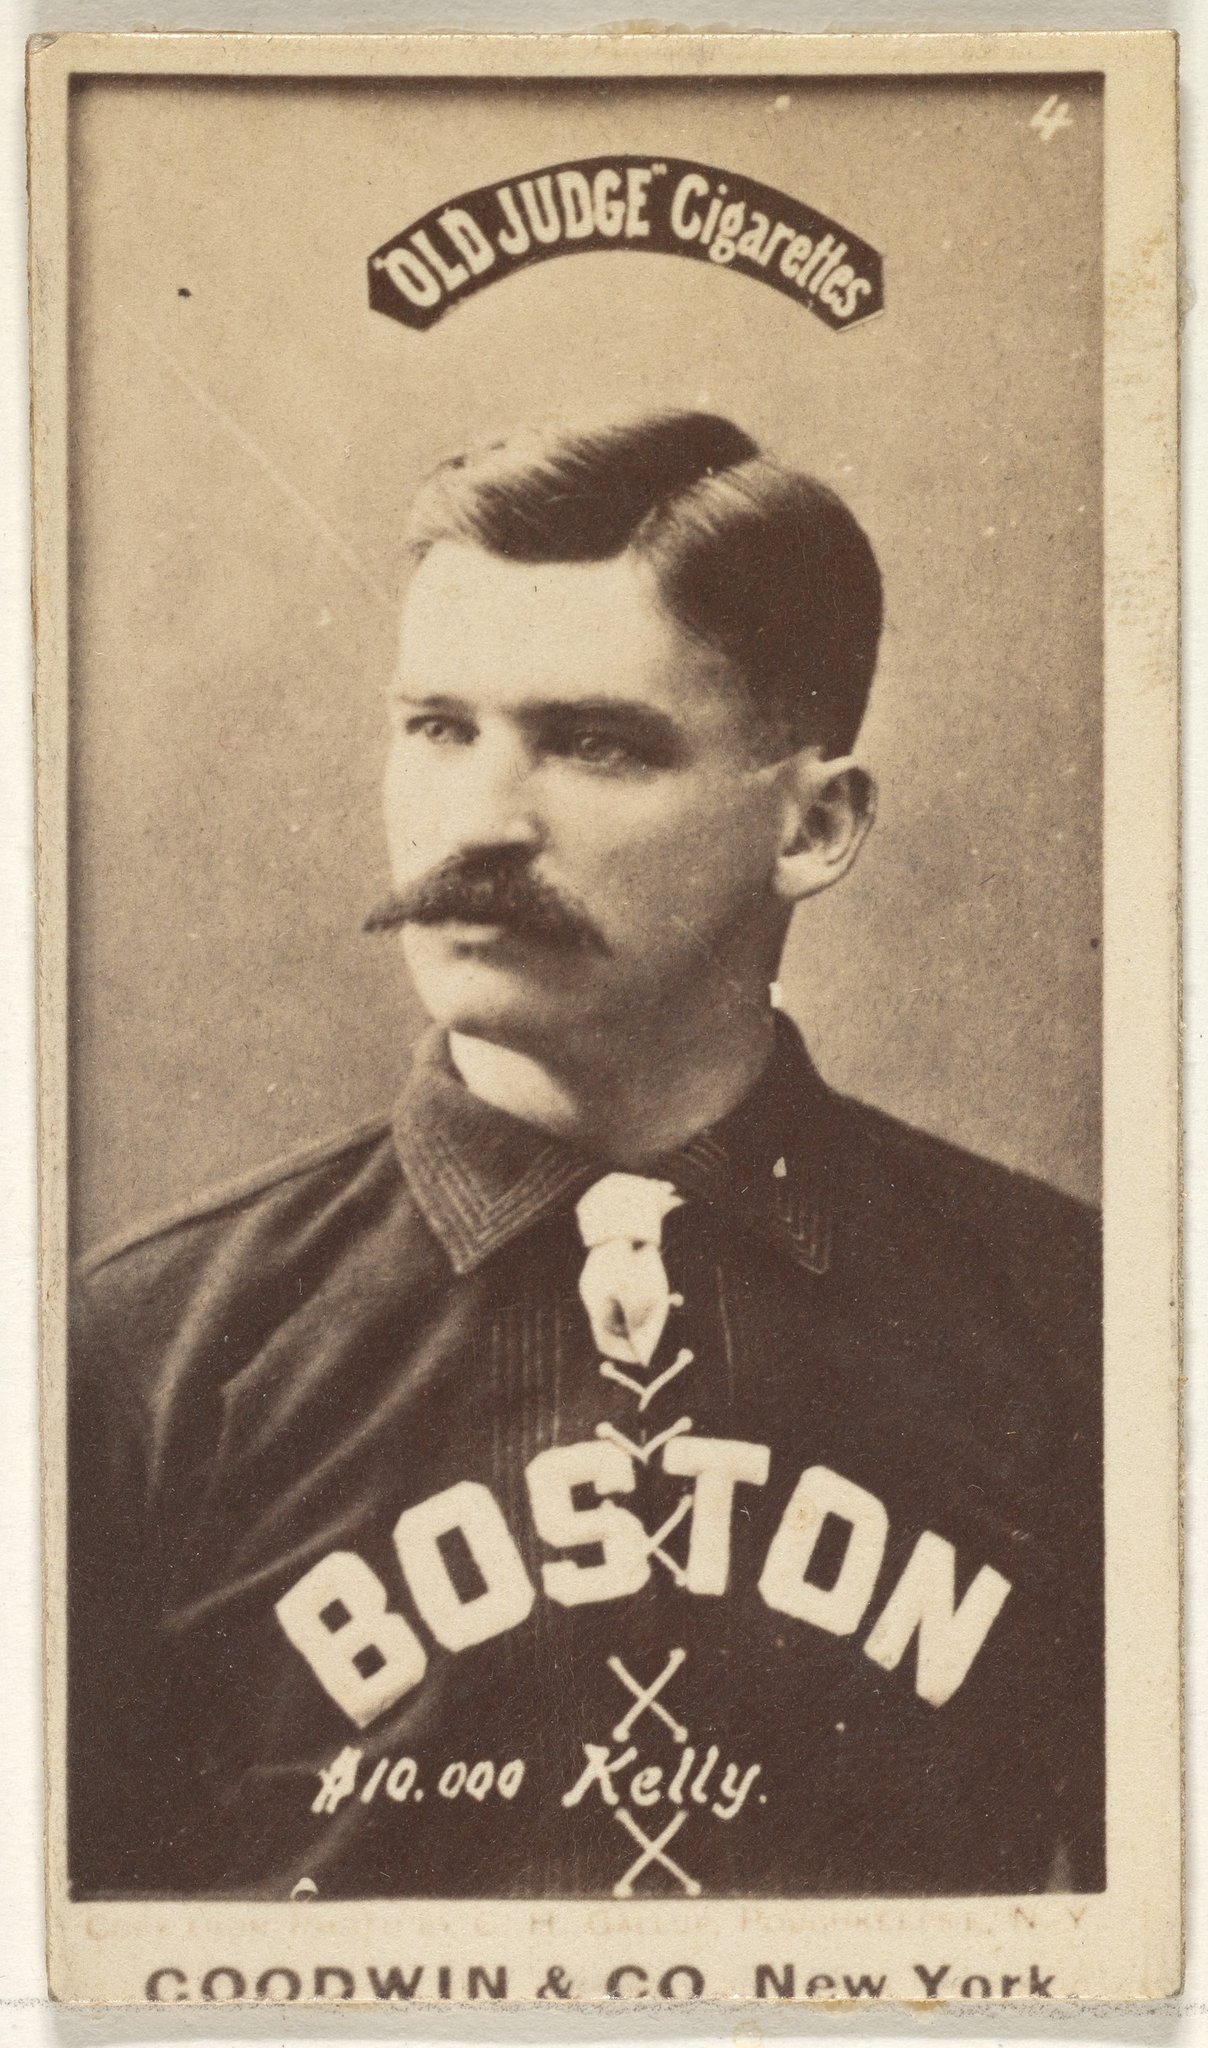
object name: baseball card, photograph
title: "$10,000" Kelly, Boston, from the Old Judge series (N172) for Old Judge Cigarettes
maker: goodwin & company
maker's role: publisher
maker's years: 1850-1950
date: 1887-1890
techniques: albumen silver print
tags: men,portraits,baseball,athletes